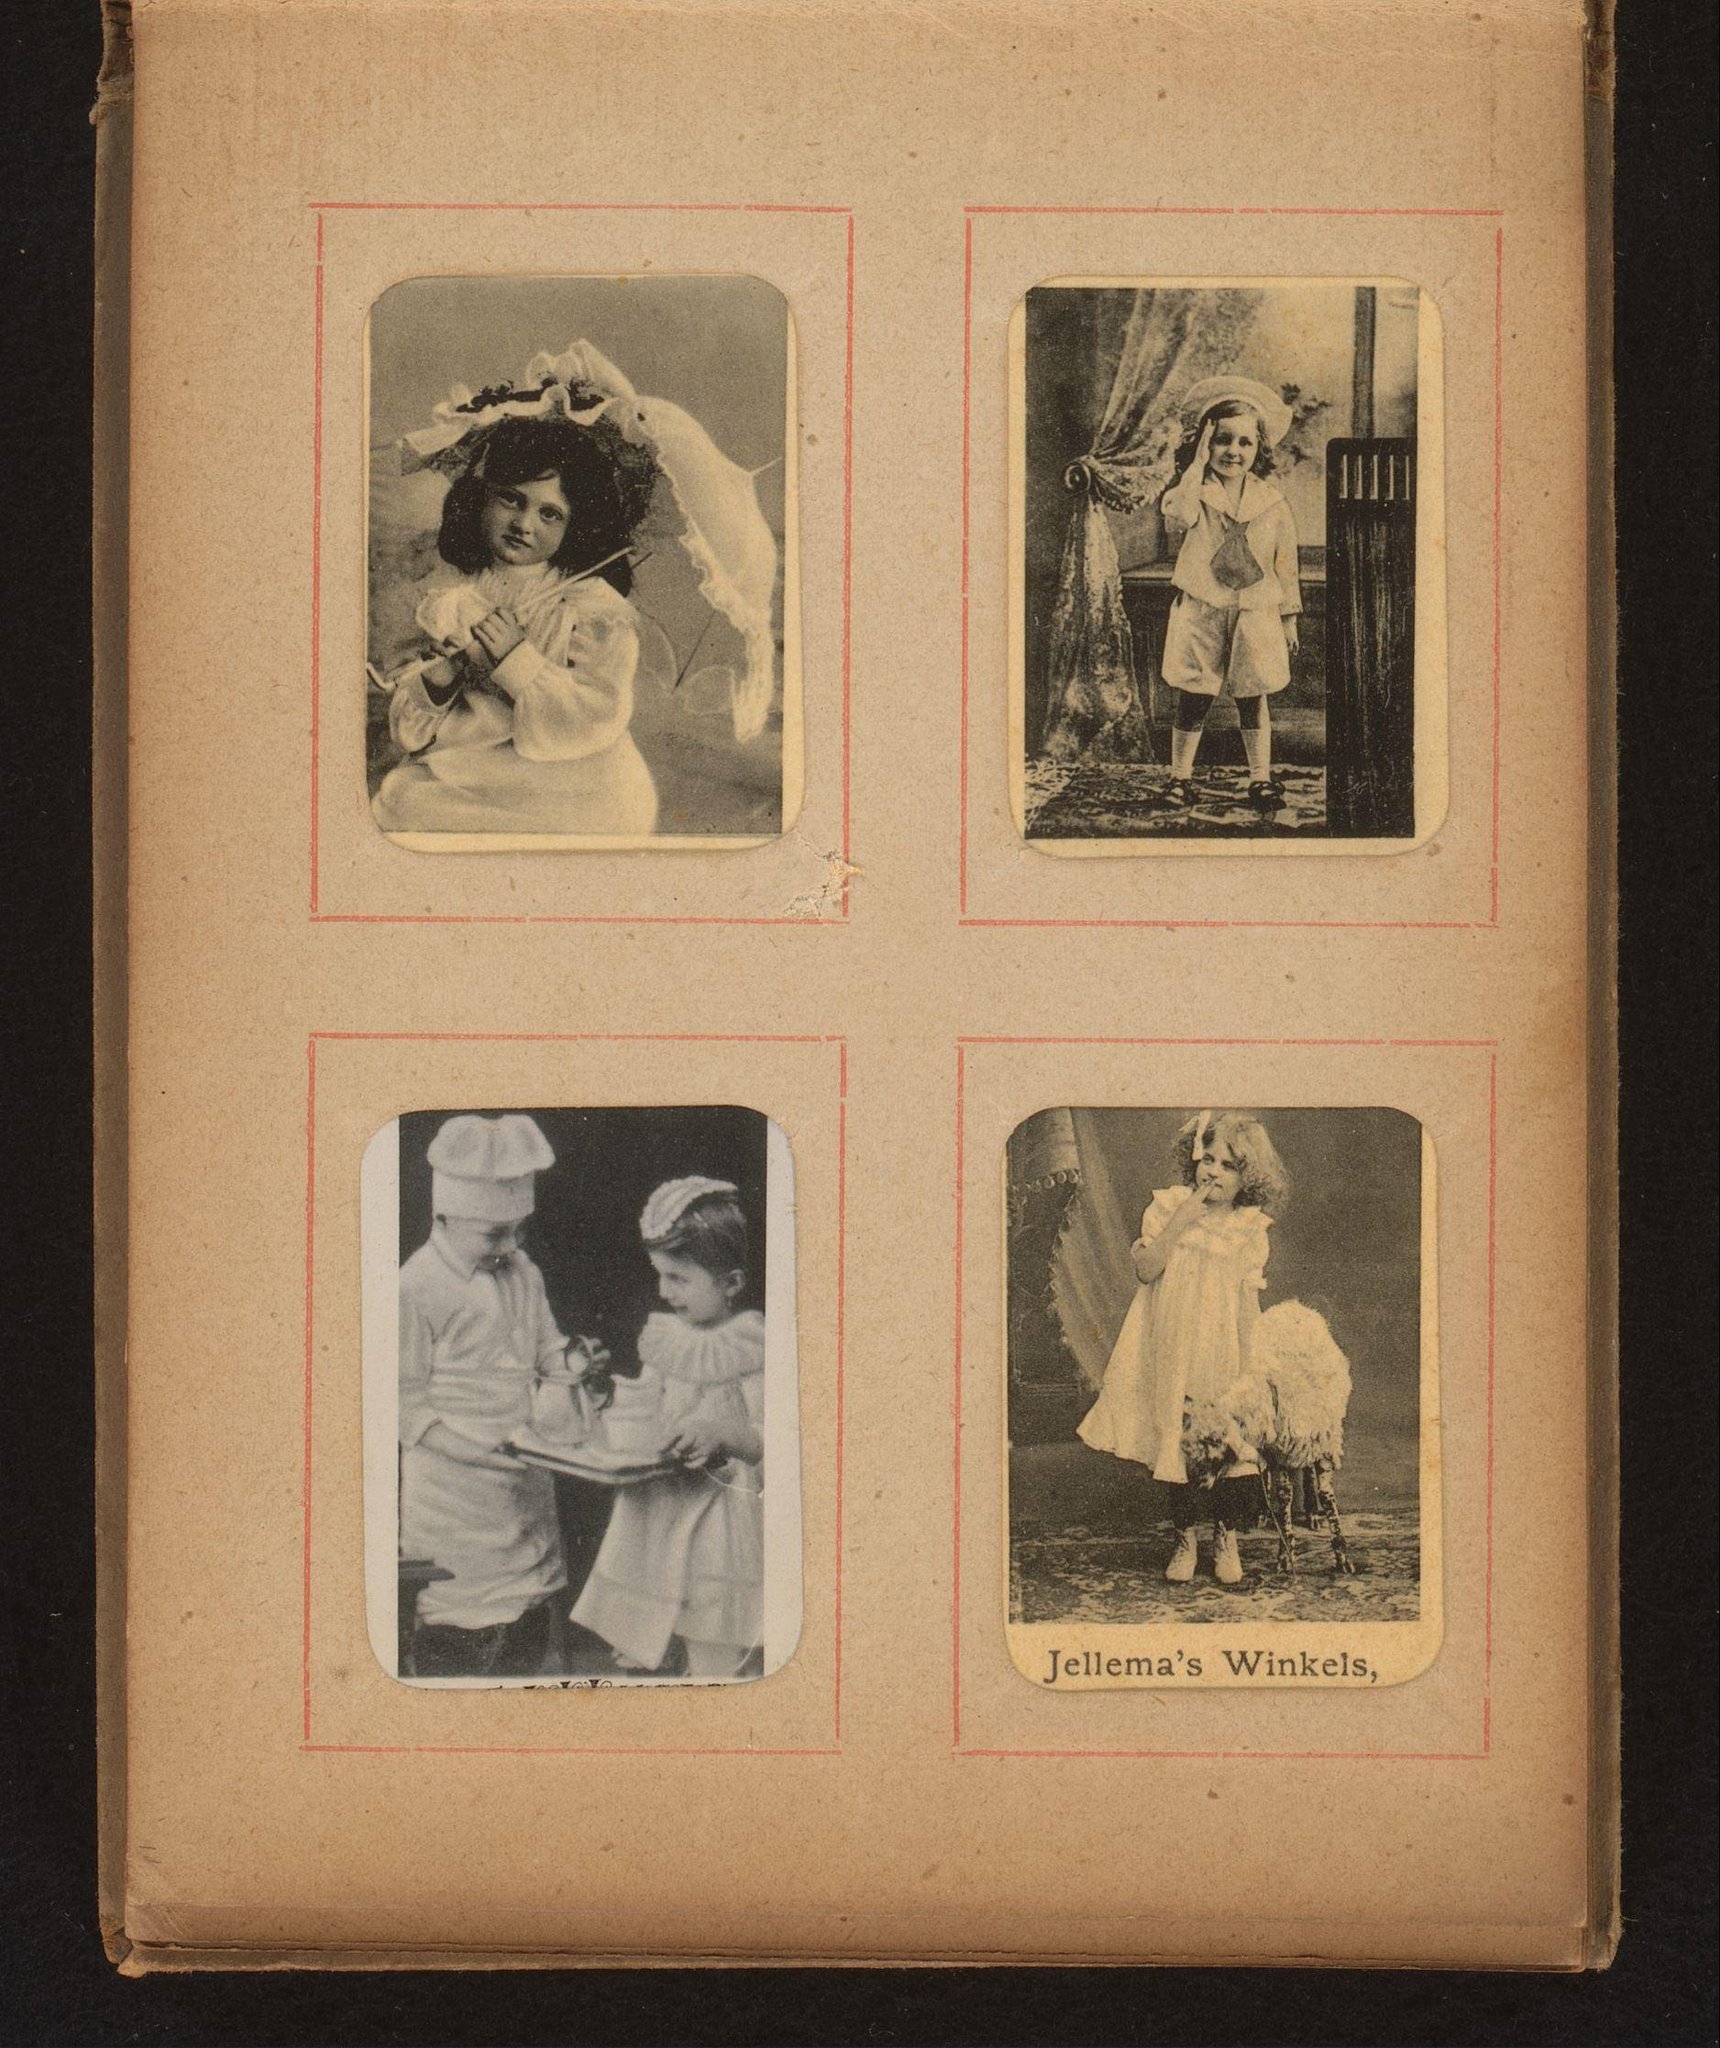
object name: album leaf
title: Kinderportretten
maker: Anonymous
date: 1880-1920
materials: paper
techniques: photograph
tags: child, umbrella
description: Vier portretten van kinderen, waaronder een met het opschrift Jellema's Winkels en een van een meisje met paraplu. Deze pagina maakt deel uit van een album.